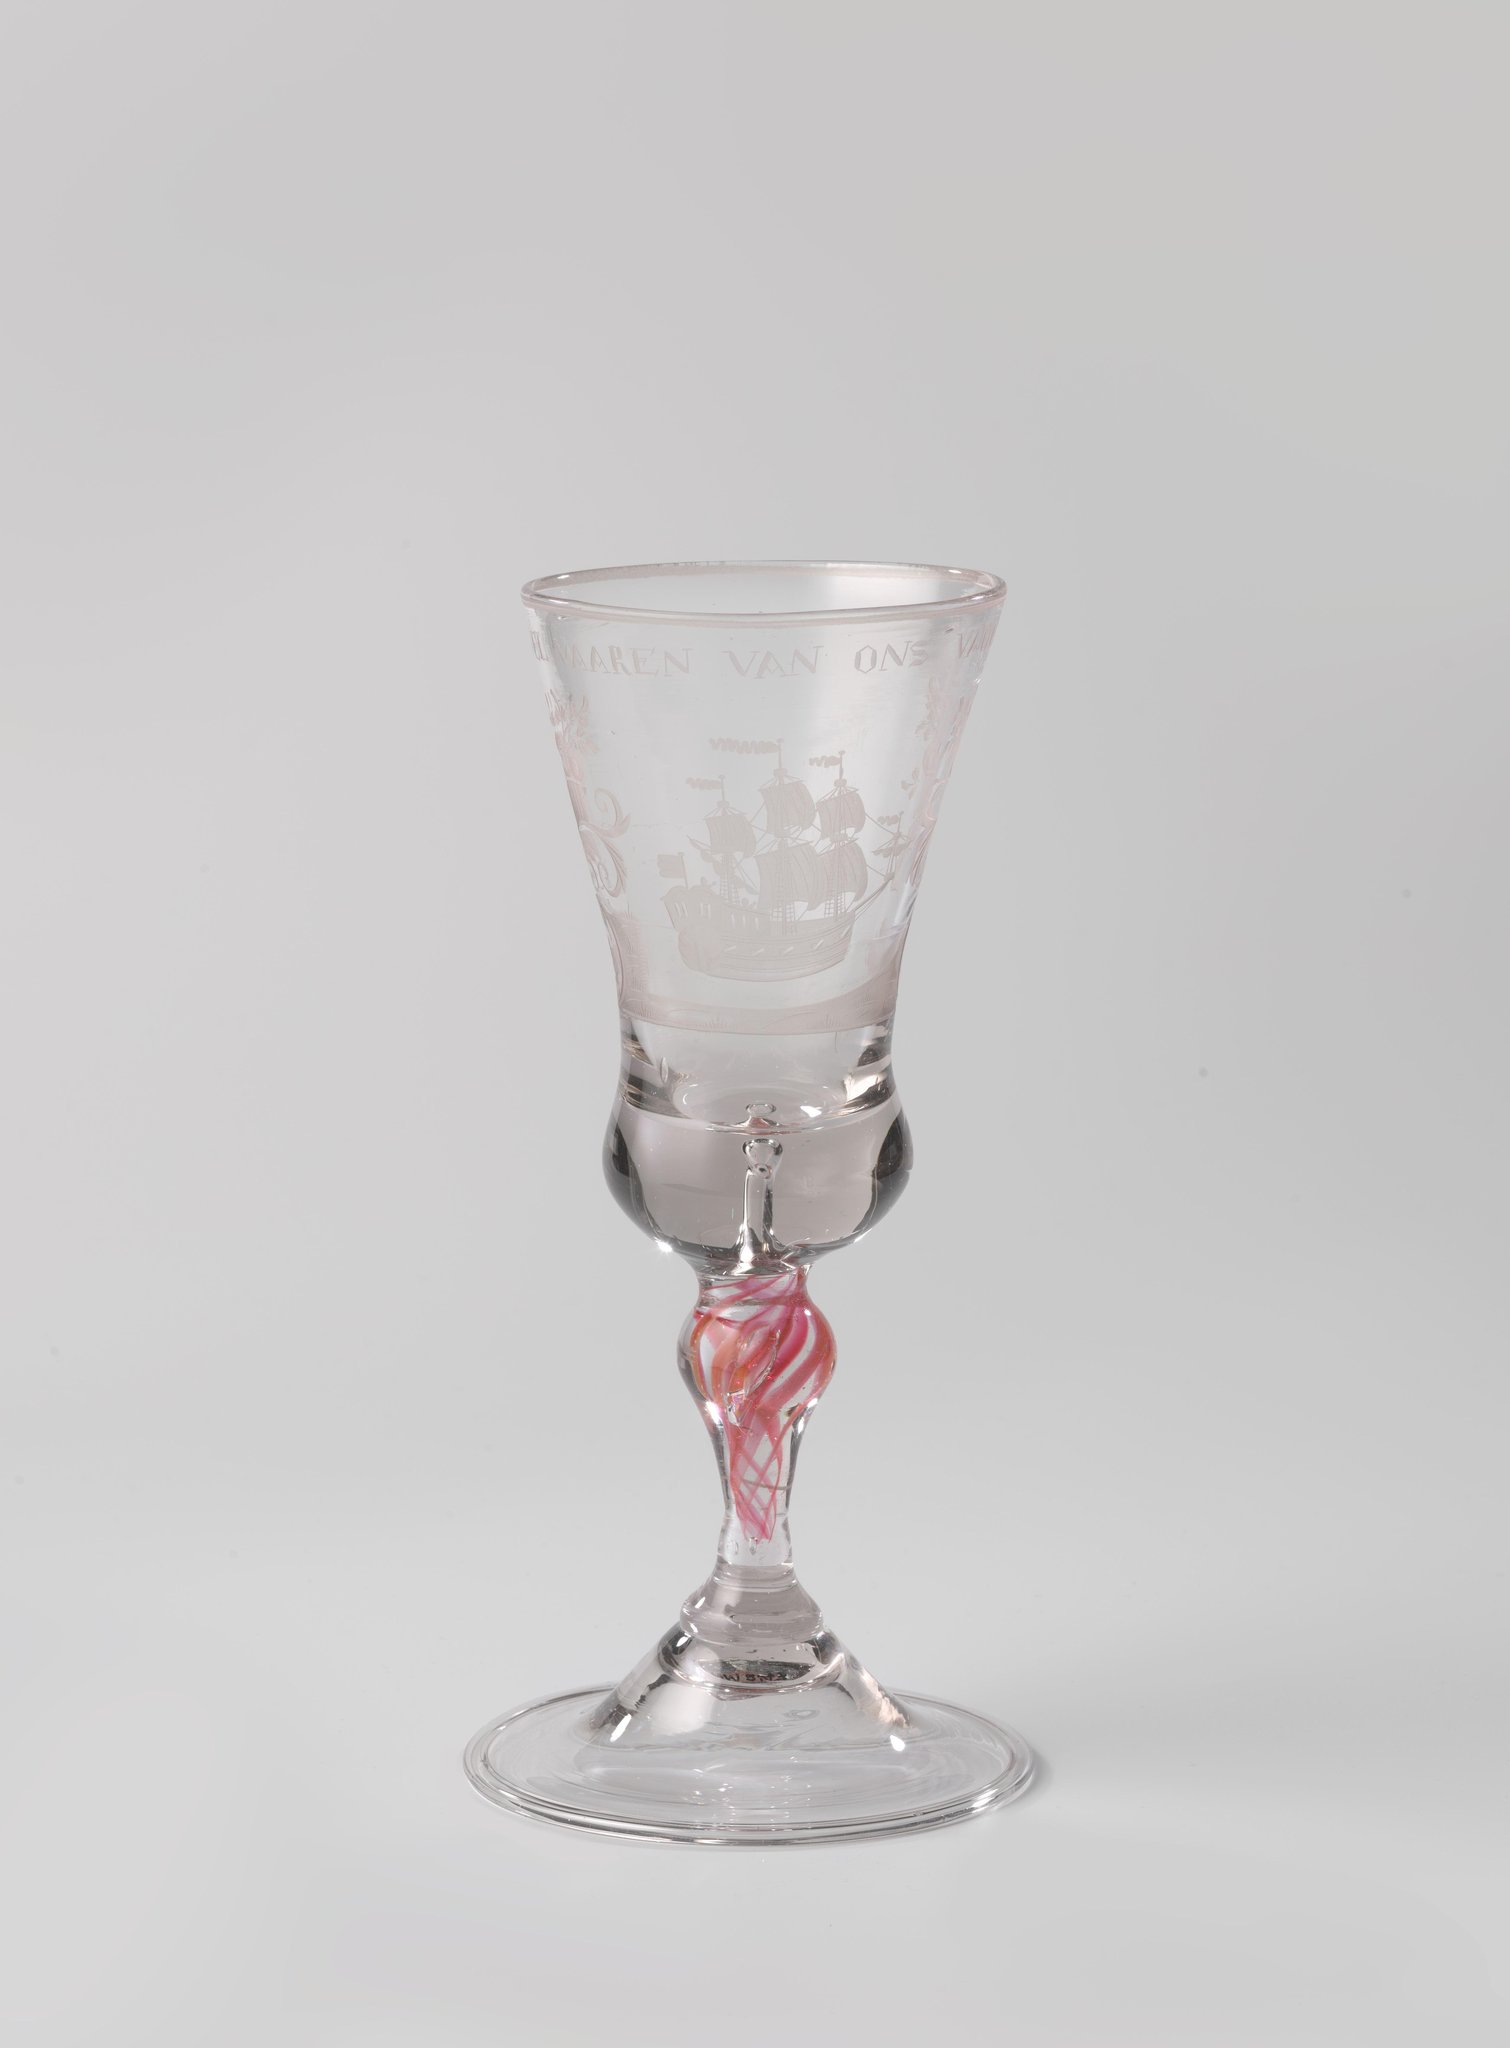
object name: goblet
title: Bokaal met een driemaster en het opschrift: T''WELVAAREN VAN ONS VADERLAND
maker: Anonymous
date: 1725-1750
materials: glass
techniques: glassblowing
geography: germany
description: Bokaal van helder, kleurloos en rood glas, met een gegraveerde voorstelling van een driemaster en het opschrift: T''WELVAAREN VAN ONS VADERLAND. In de stam rode draden.